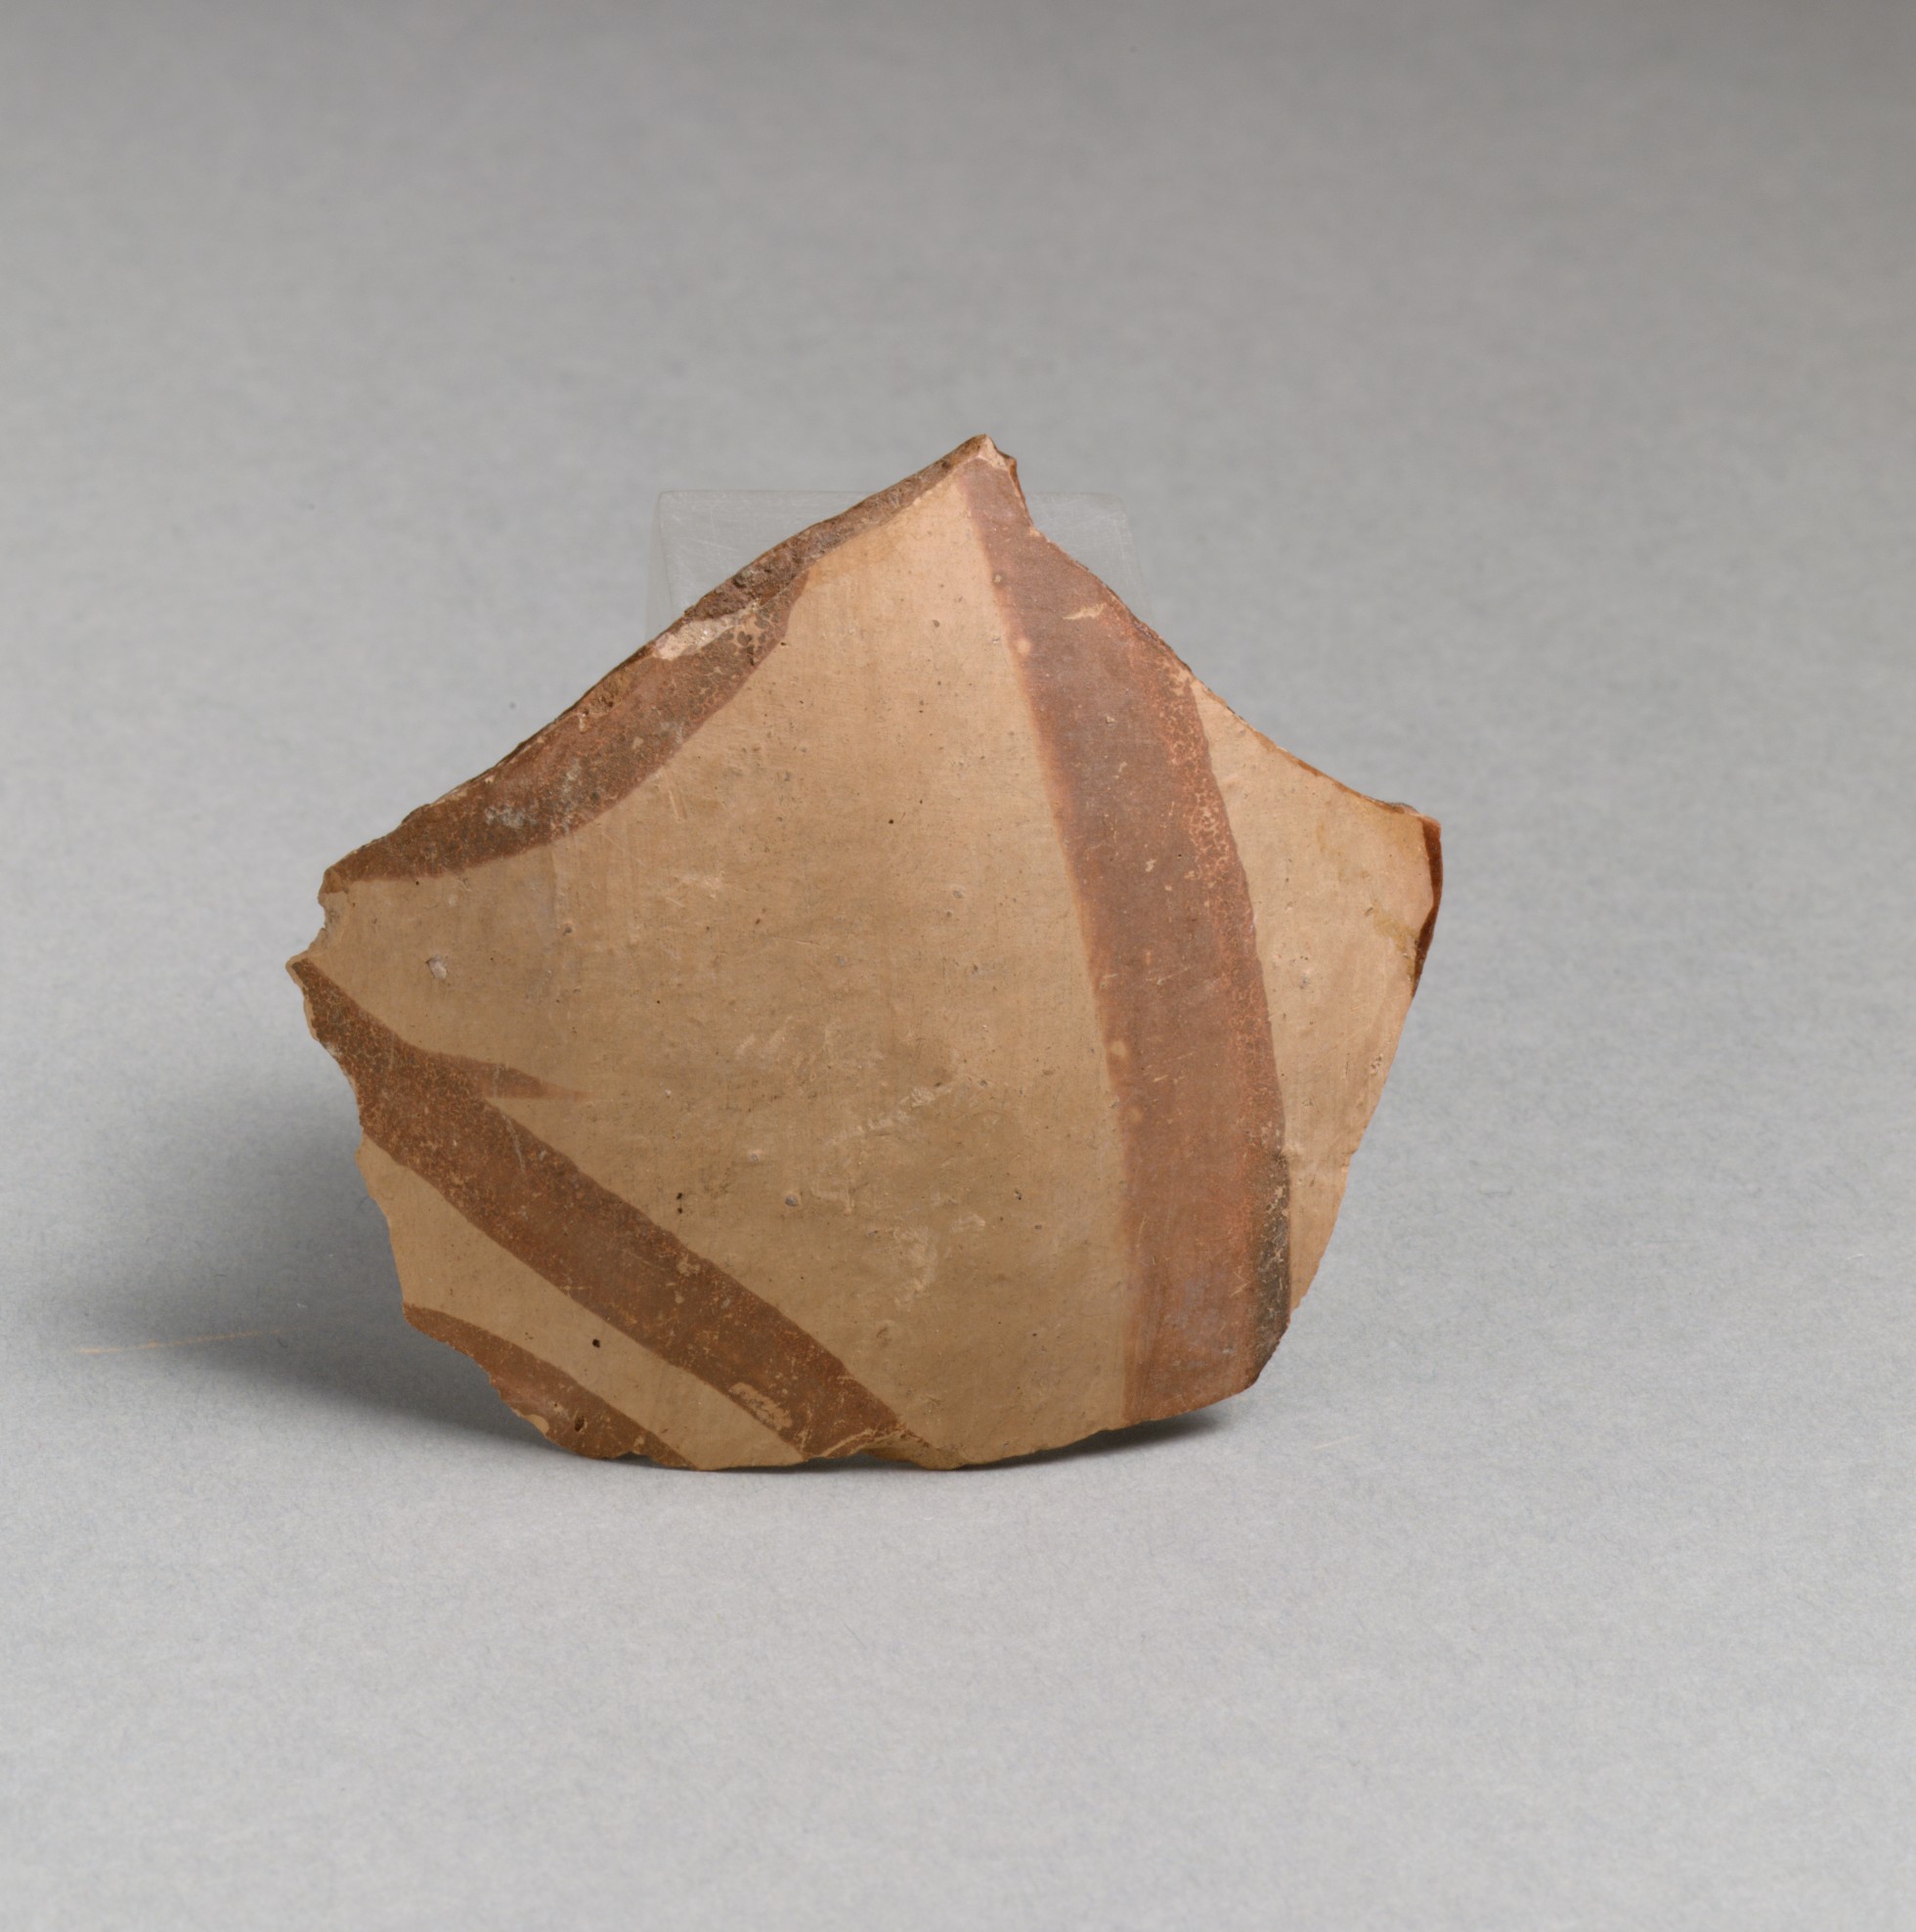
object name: vase fragment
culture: minoan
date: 1600-1450 BCE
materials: terracotta